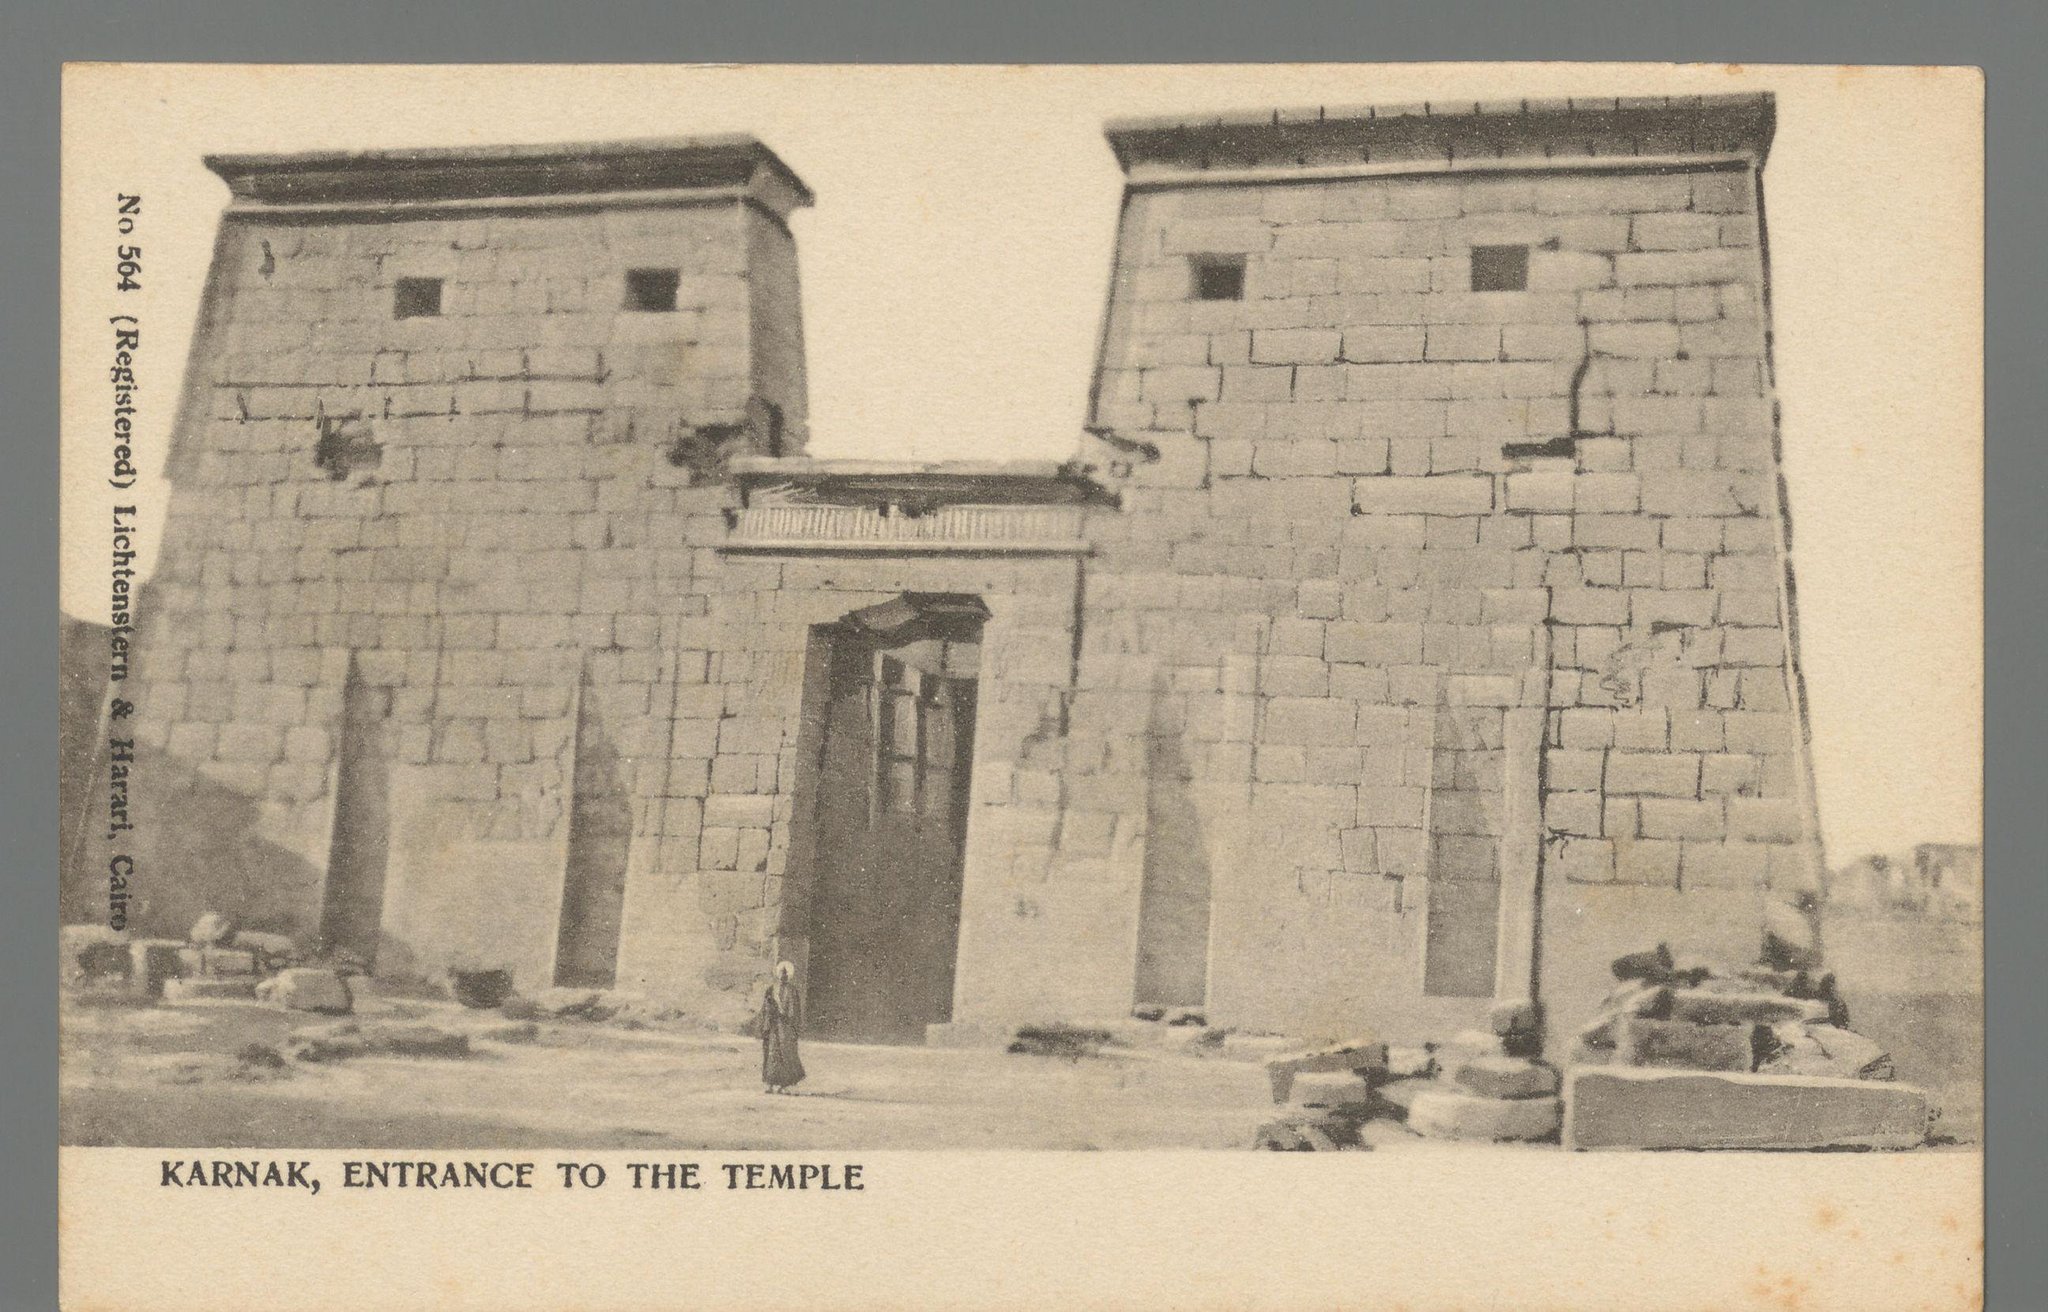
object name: photomechanical print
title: Karnak, entrance to the temple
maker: Anonymous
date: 1900-1907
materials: cardboard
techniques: photograph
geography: karnak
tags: temple, shrine ~ egyptian religion, gate, entrance